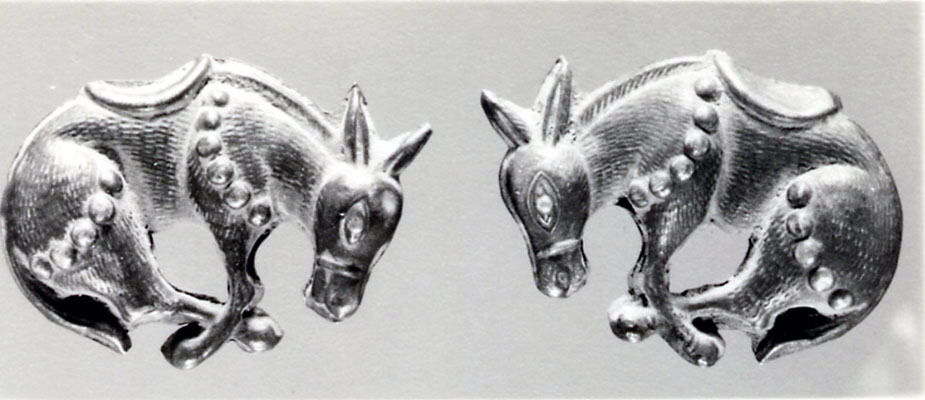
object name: rattle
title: Rattle?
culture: chinese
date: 220-589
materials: bronze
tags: donkeys